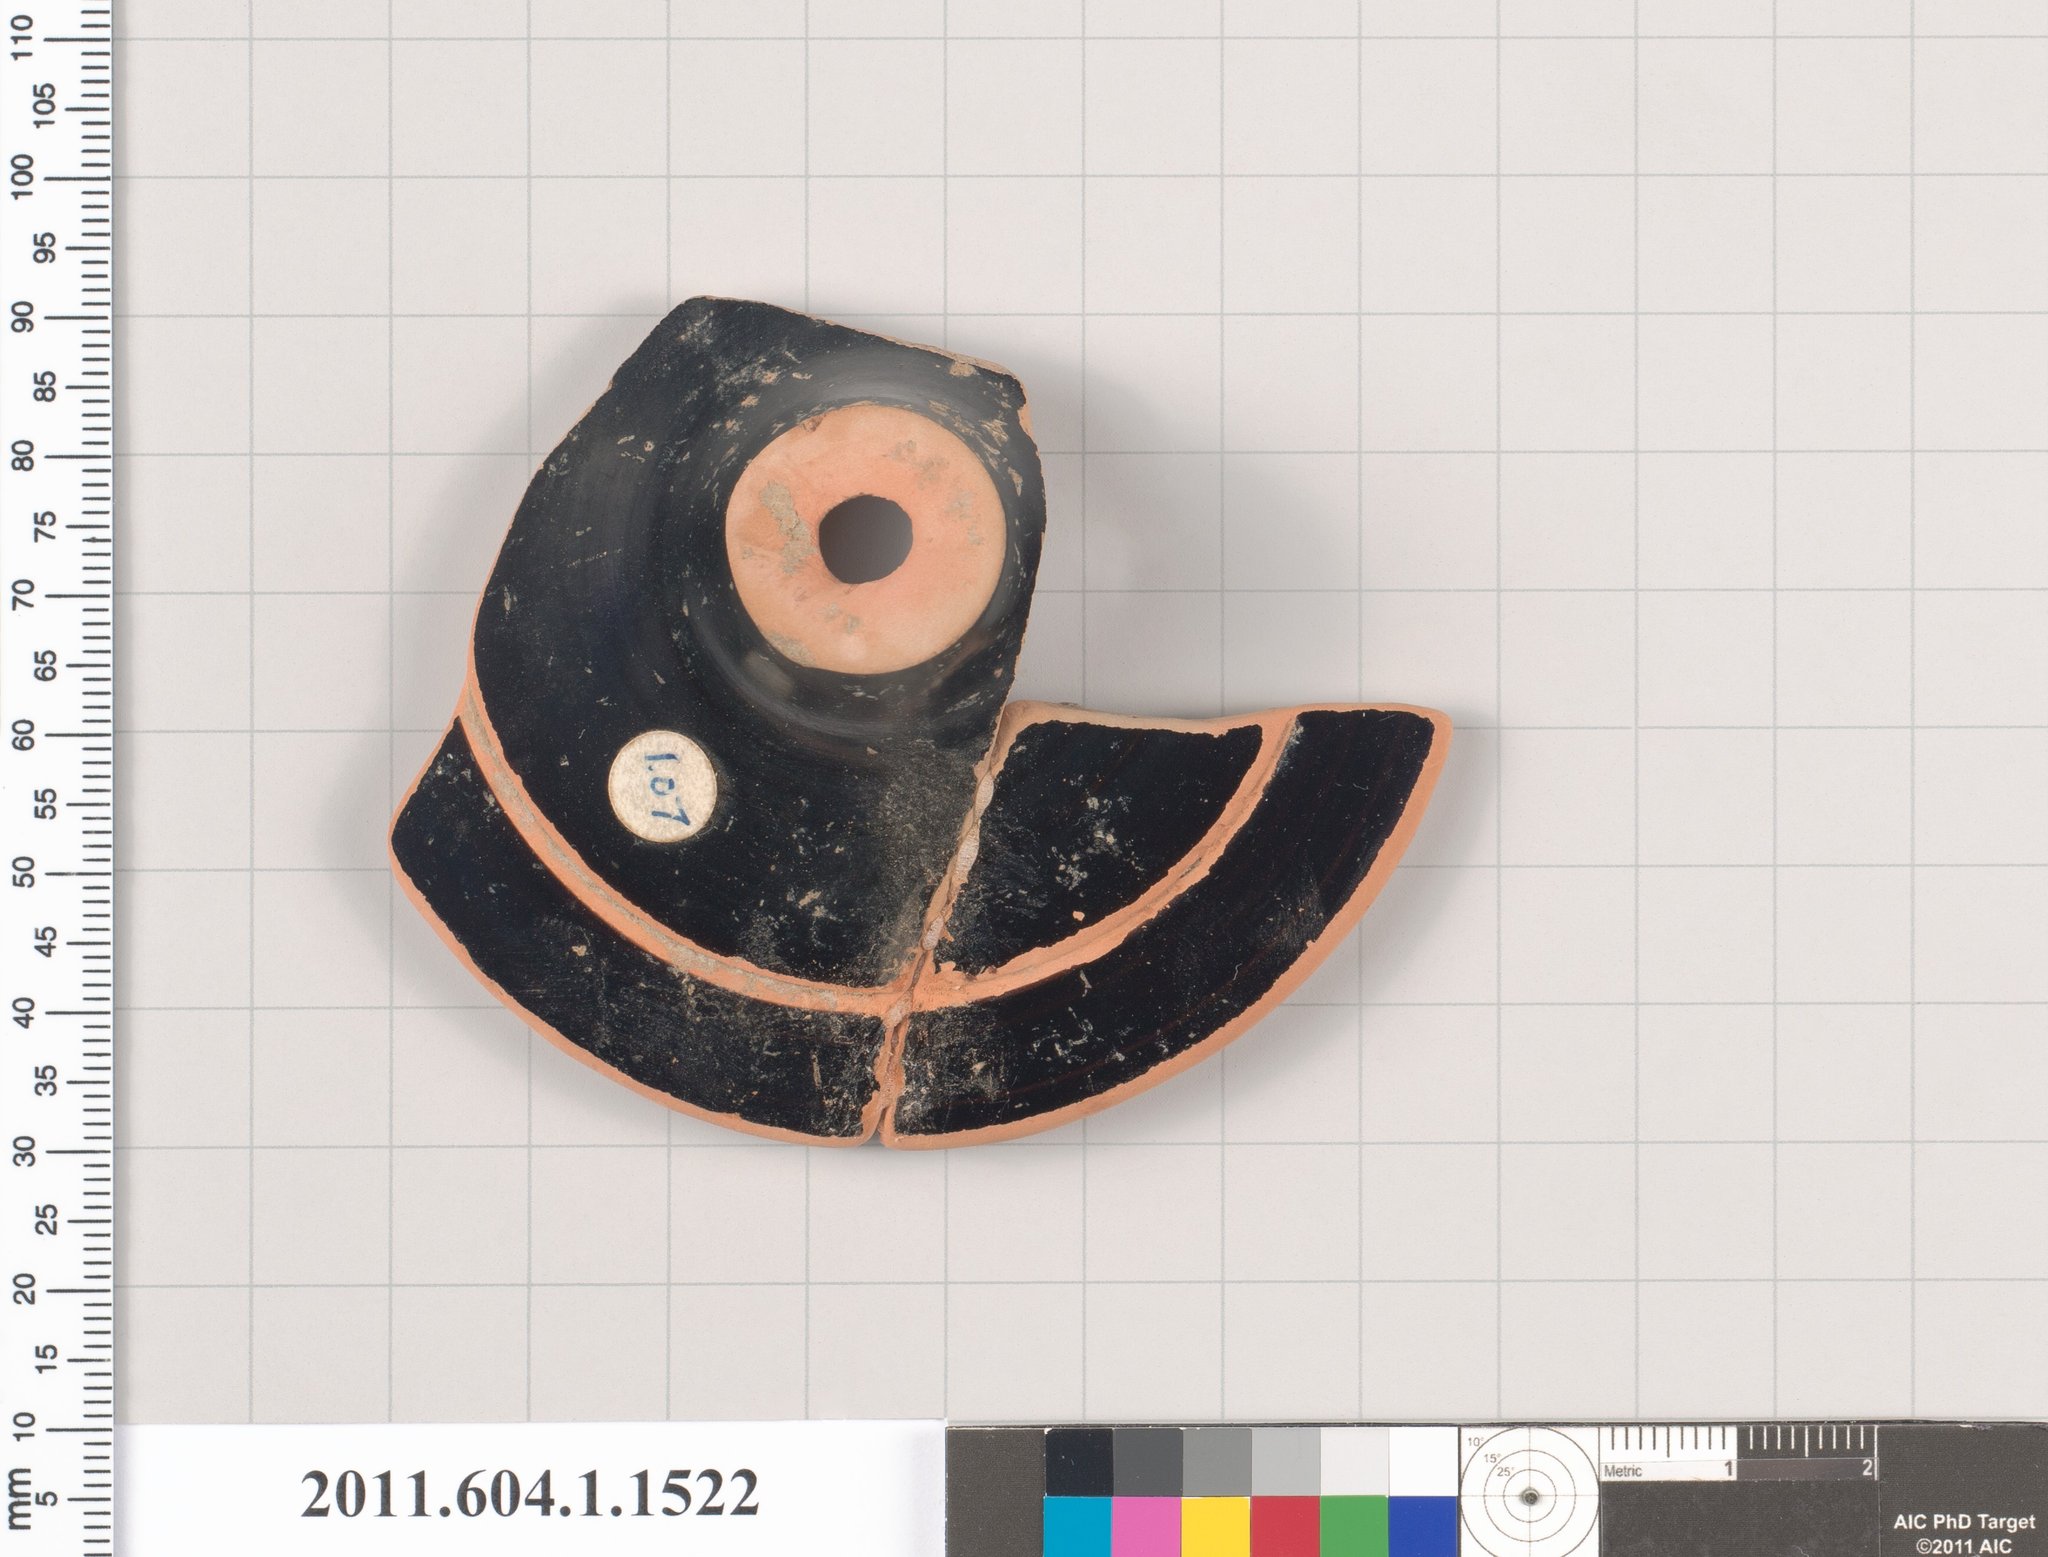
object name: kylix fragment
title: Terracotta fragment of a kylix (drinking cup)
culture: greek, attic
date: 500-401 BCE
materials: terracotta